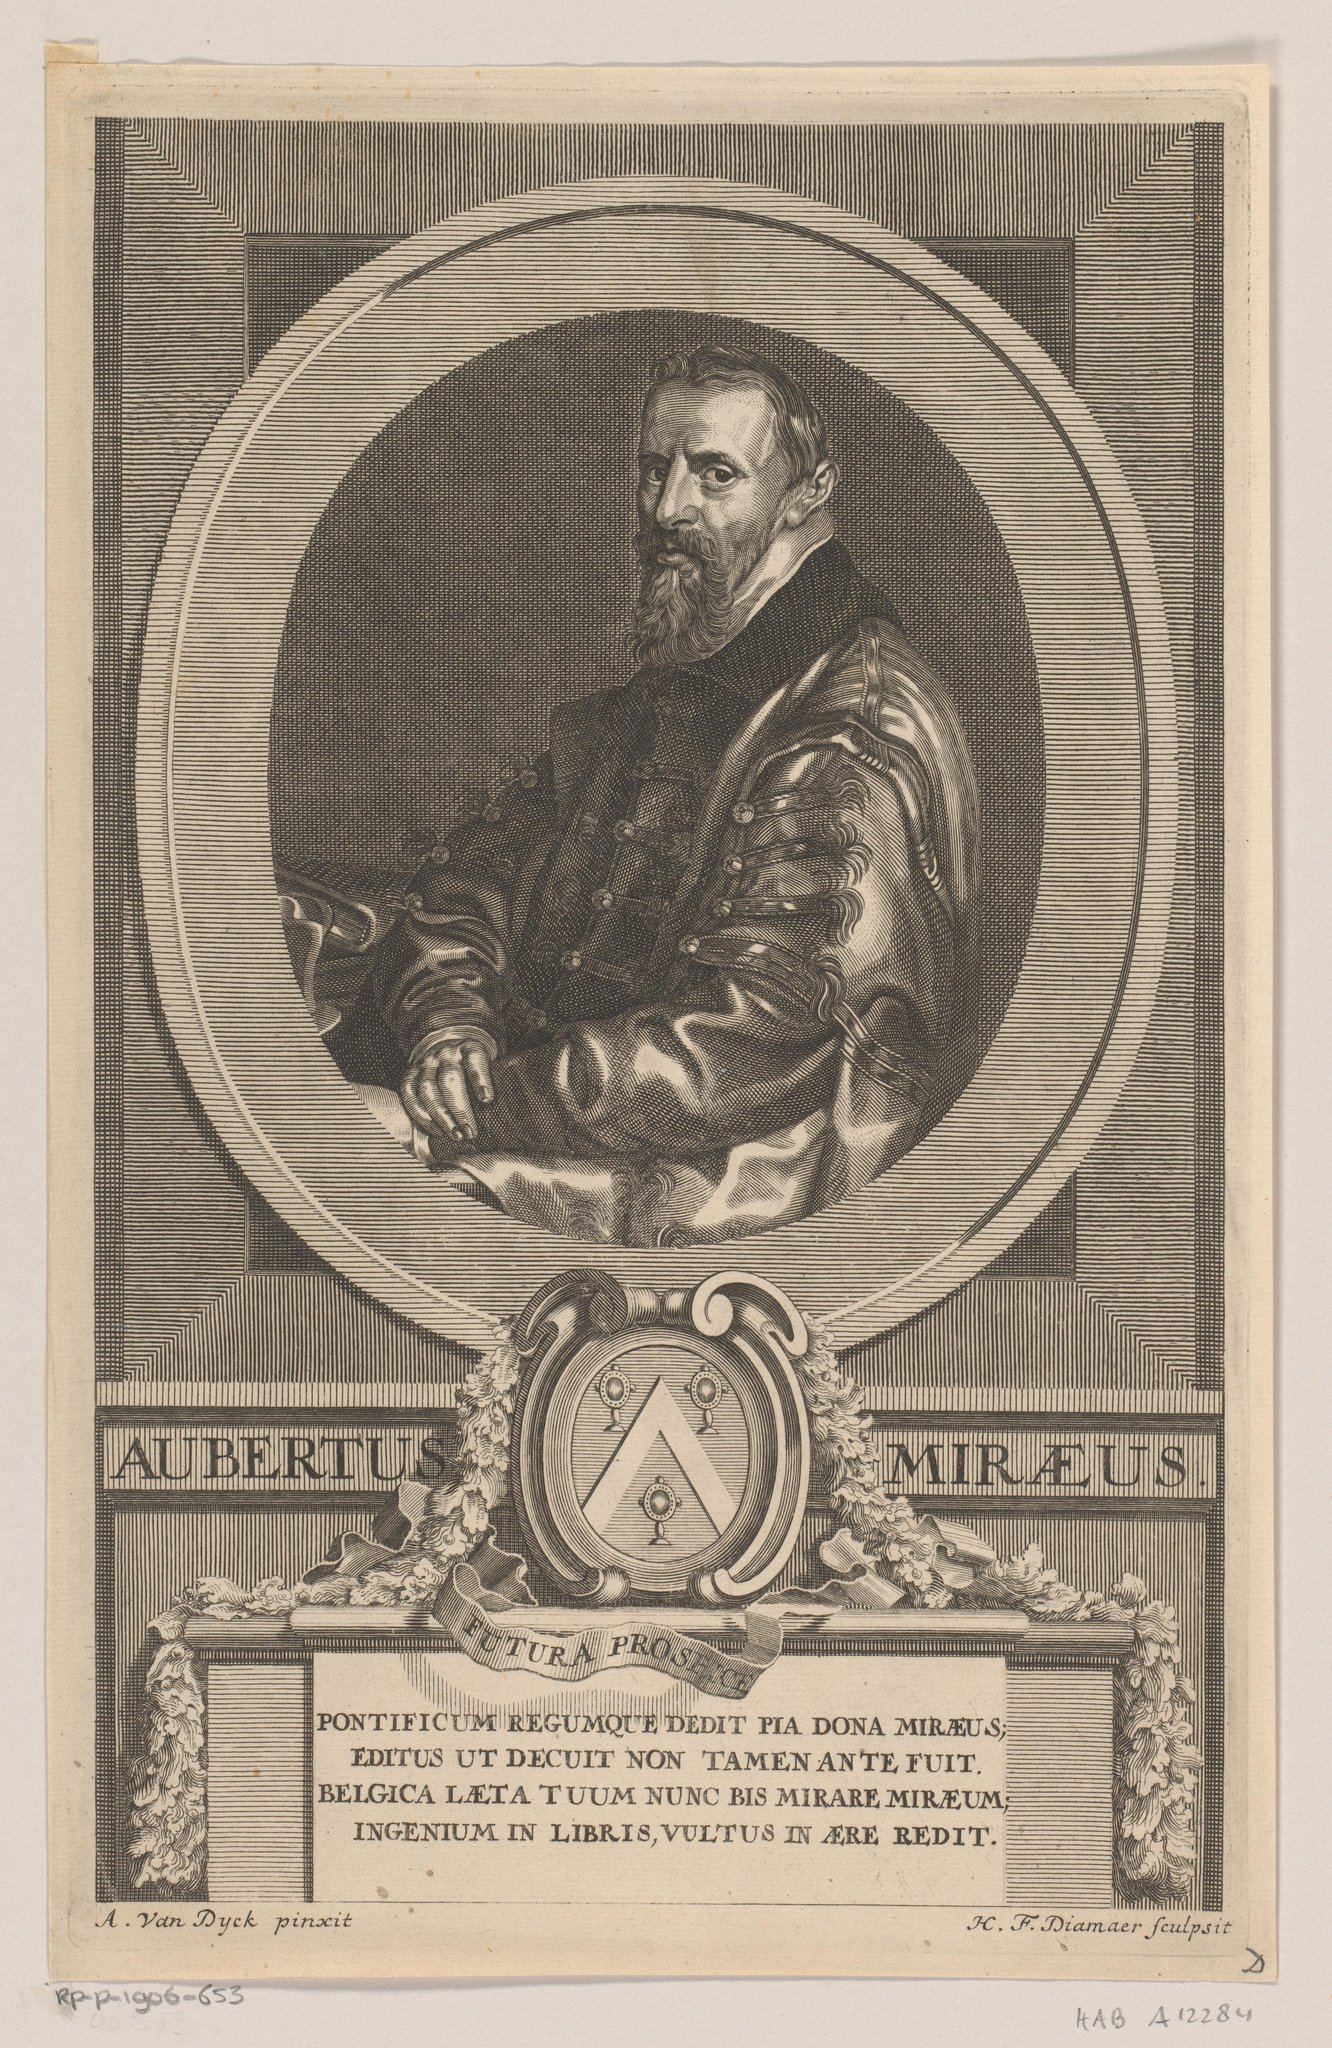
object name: print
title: Portret van Aubert le Mire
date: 1723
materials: paper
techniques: engraving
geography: antwerp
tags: brussels, antwerp, aubert le mire, hierarchy of jurisdiction ~ eastern, greek and russian orthodox churches, historical persons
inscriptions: collector's mark: Lugt 2228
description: Prent waarschijnlijk: Mire, Aubert le. Opera diplomatica et historica (...). Brussel: Frans Foppens, 1723.